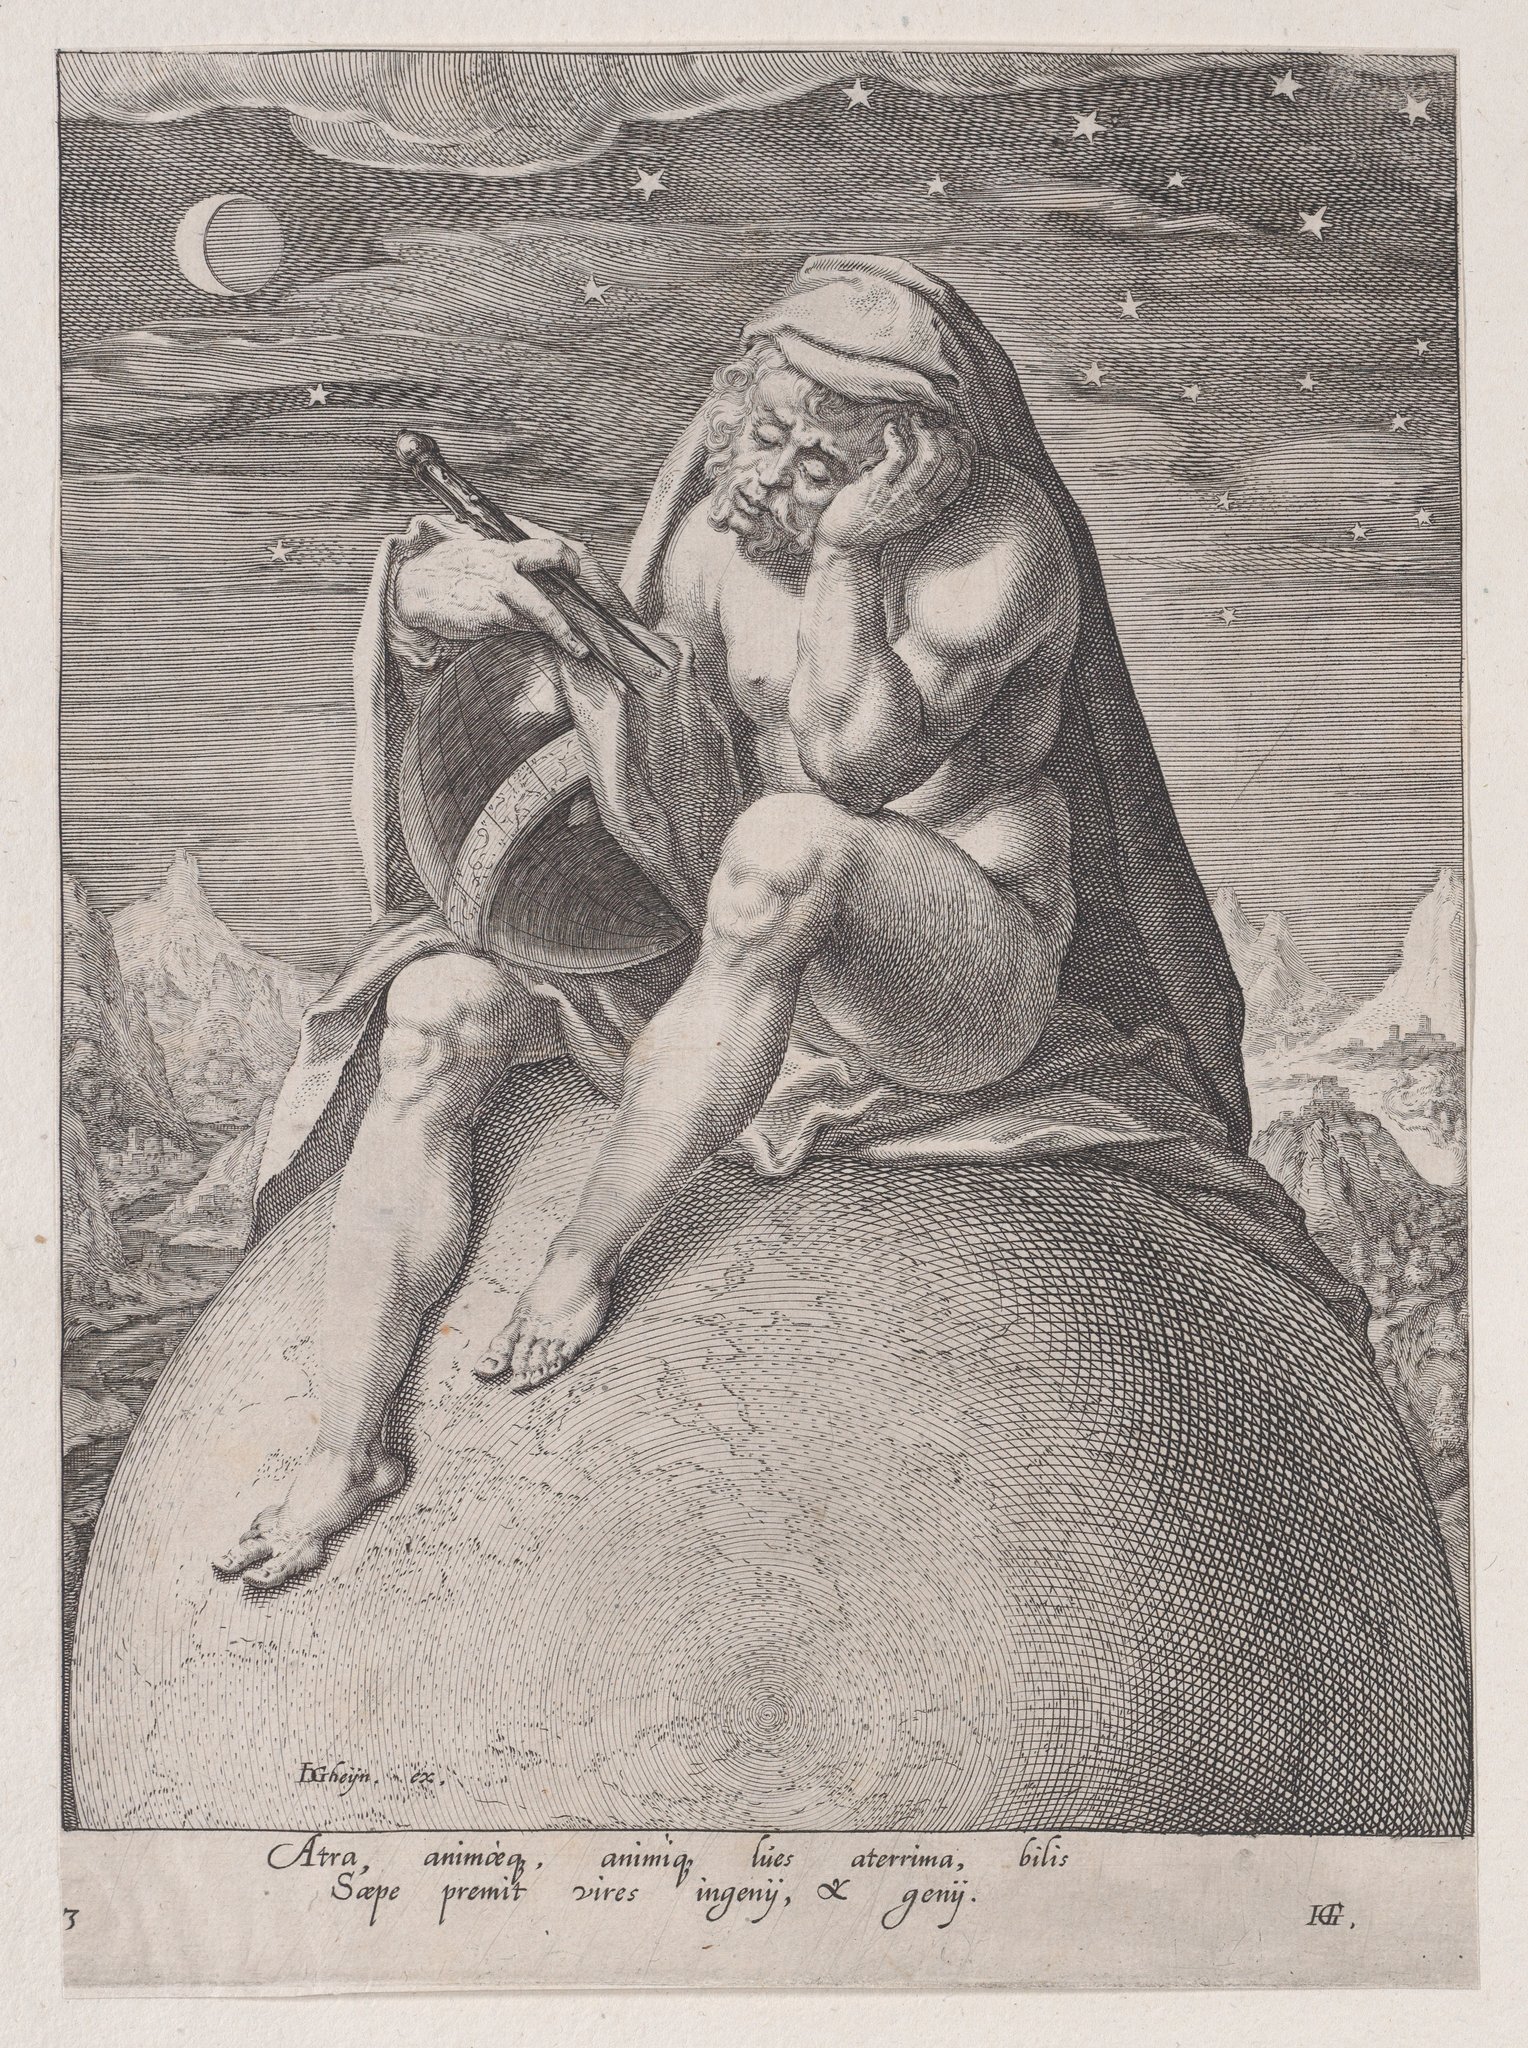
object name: print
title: Air (Melancholicus), from "The Four Temperaments"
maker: jacques de gheyn (ii)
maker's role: artist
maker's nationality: netherlandish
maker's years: 1565-1629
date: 1596-1597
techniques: engraving